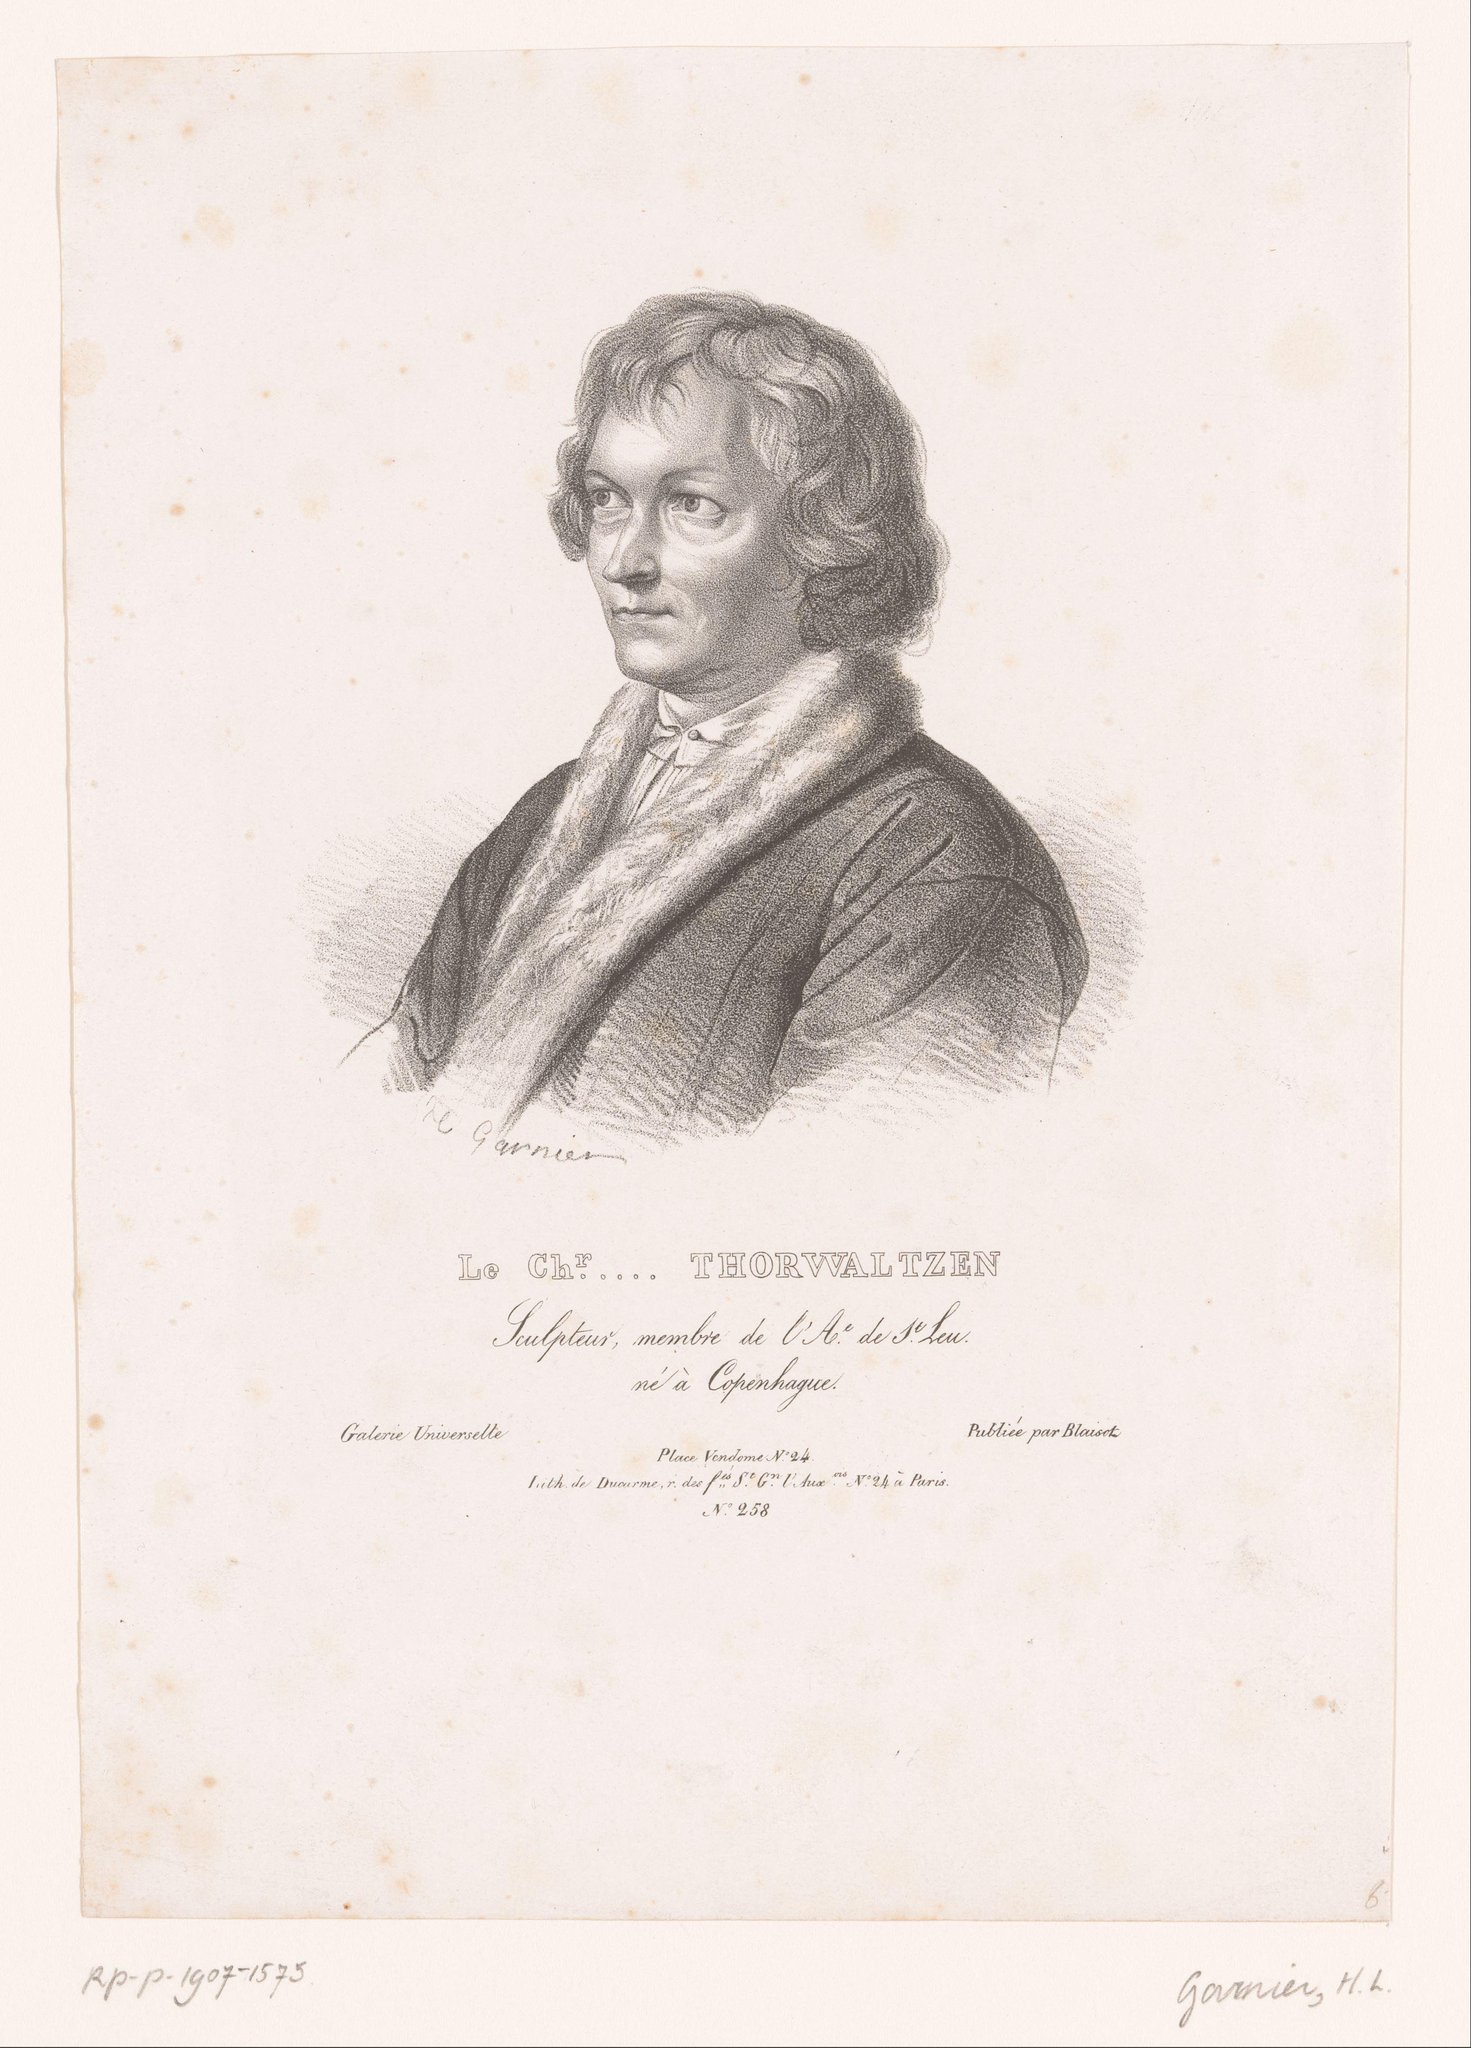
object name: print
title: Portret van Bertel Thorvaldsen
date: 1823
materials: paper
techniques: lithograph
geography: paris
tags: copenhagen (city), draughtsman, sculptor, bertel thorvaldsen, historical persons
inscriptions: collector's mark: Lugt 2228a, check stamp: ‘Gbr. Gropius. / Im Diorama / In Berlin’